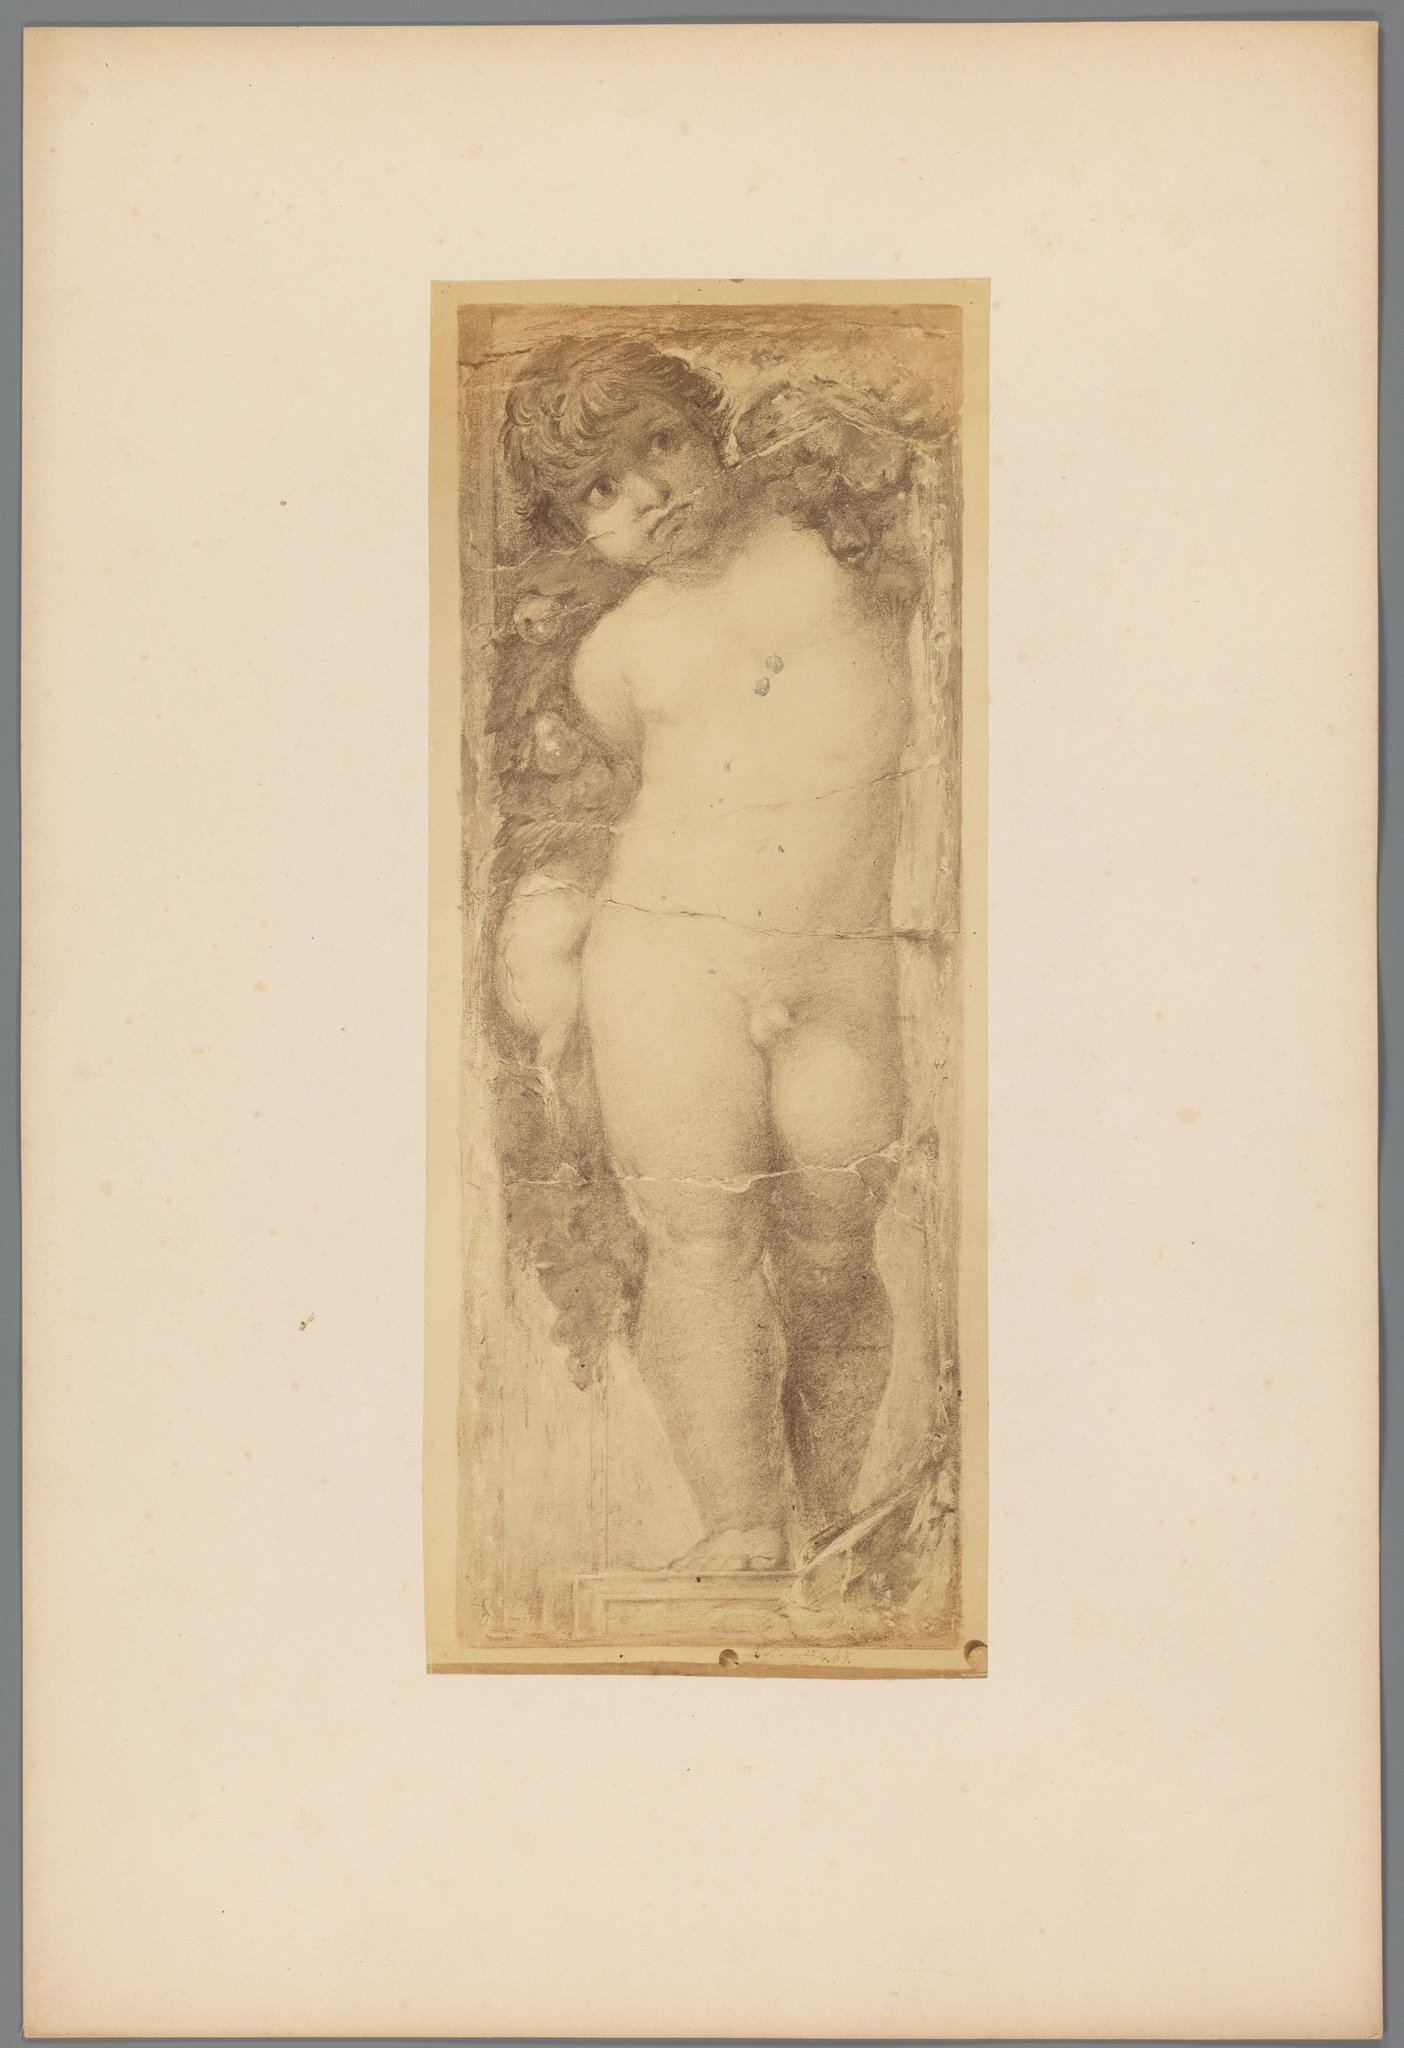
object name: reproduction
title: Fotoreproductie van een fresco voorstellende een engel of putto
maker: Anonymous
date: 1851-1900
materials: cardboard, paper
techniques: albumen print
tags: picture, painting, angels